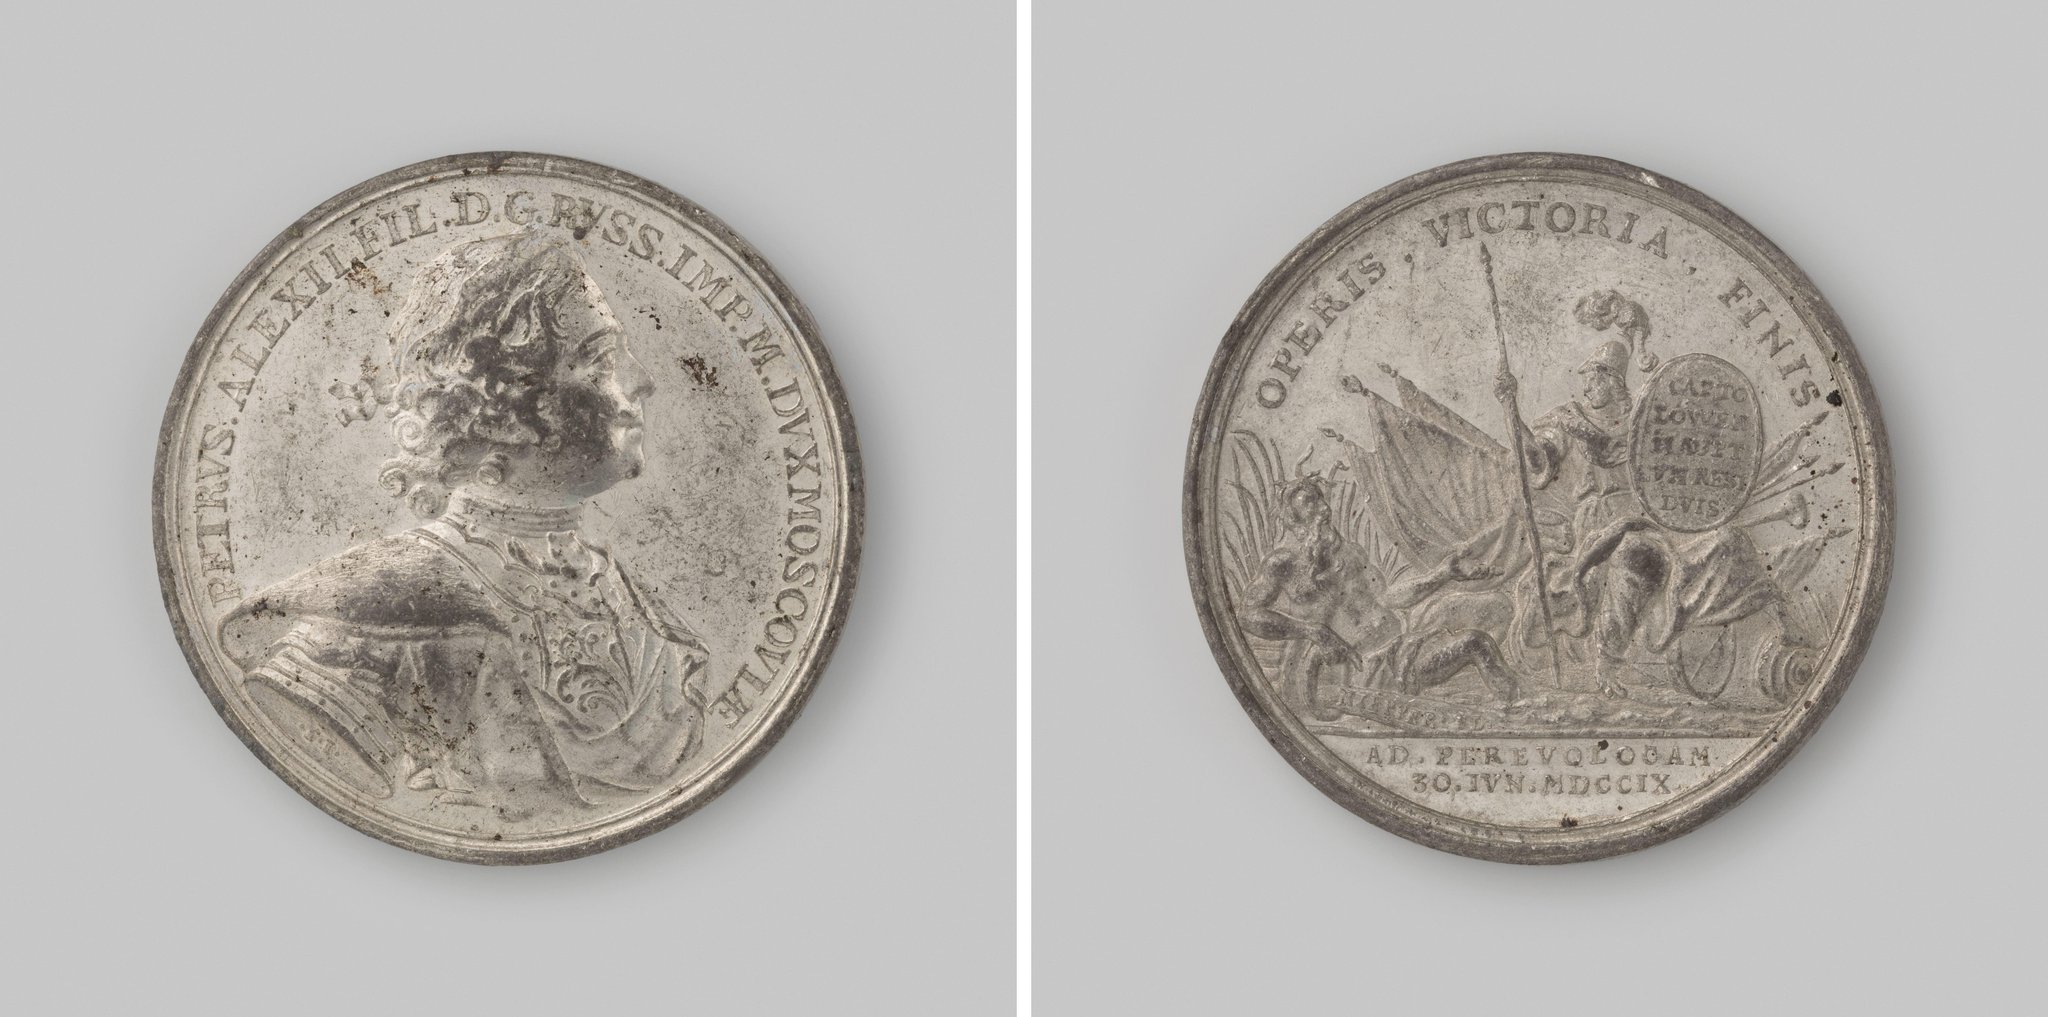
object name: history medal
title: Gevangenneming van het Zweedse leger onder Löwenhaupt door Rusland 1709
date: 1709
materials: tin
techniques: striking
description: Tinnen penning, op de voorzijde het borstbeeld van Tsaar Peter de Grote naar rechts met omschrift, op de keerzijde Minerva te midden van militaire trofeëen met links een zitende riviergod, met omschrift en afsnedetekst.